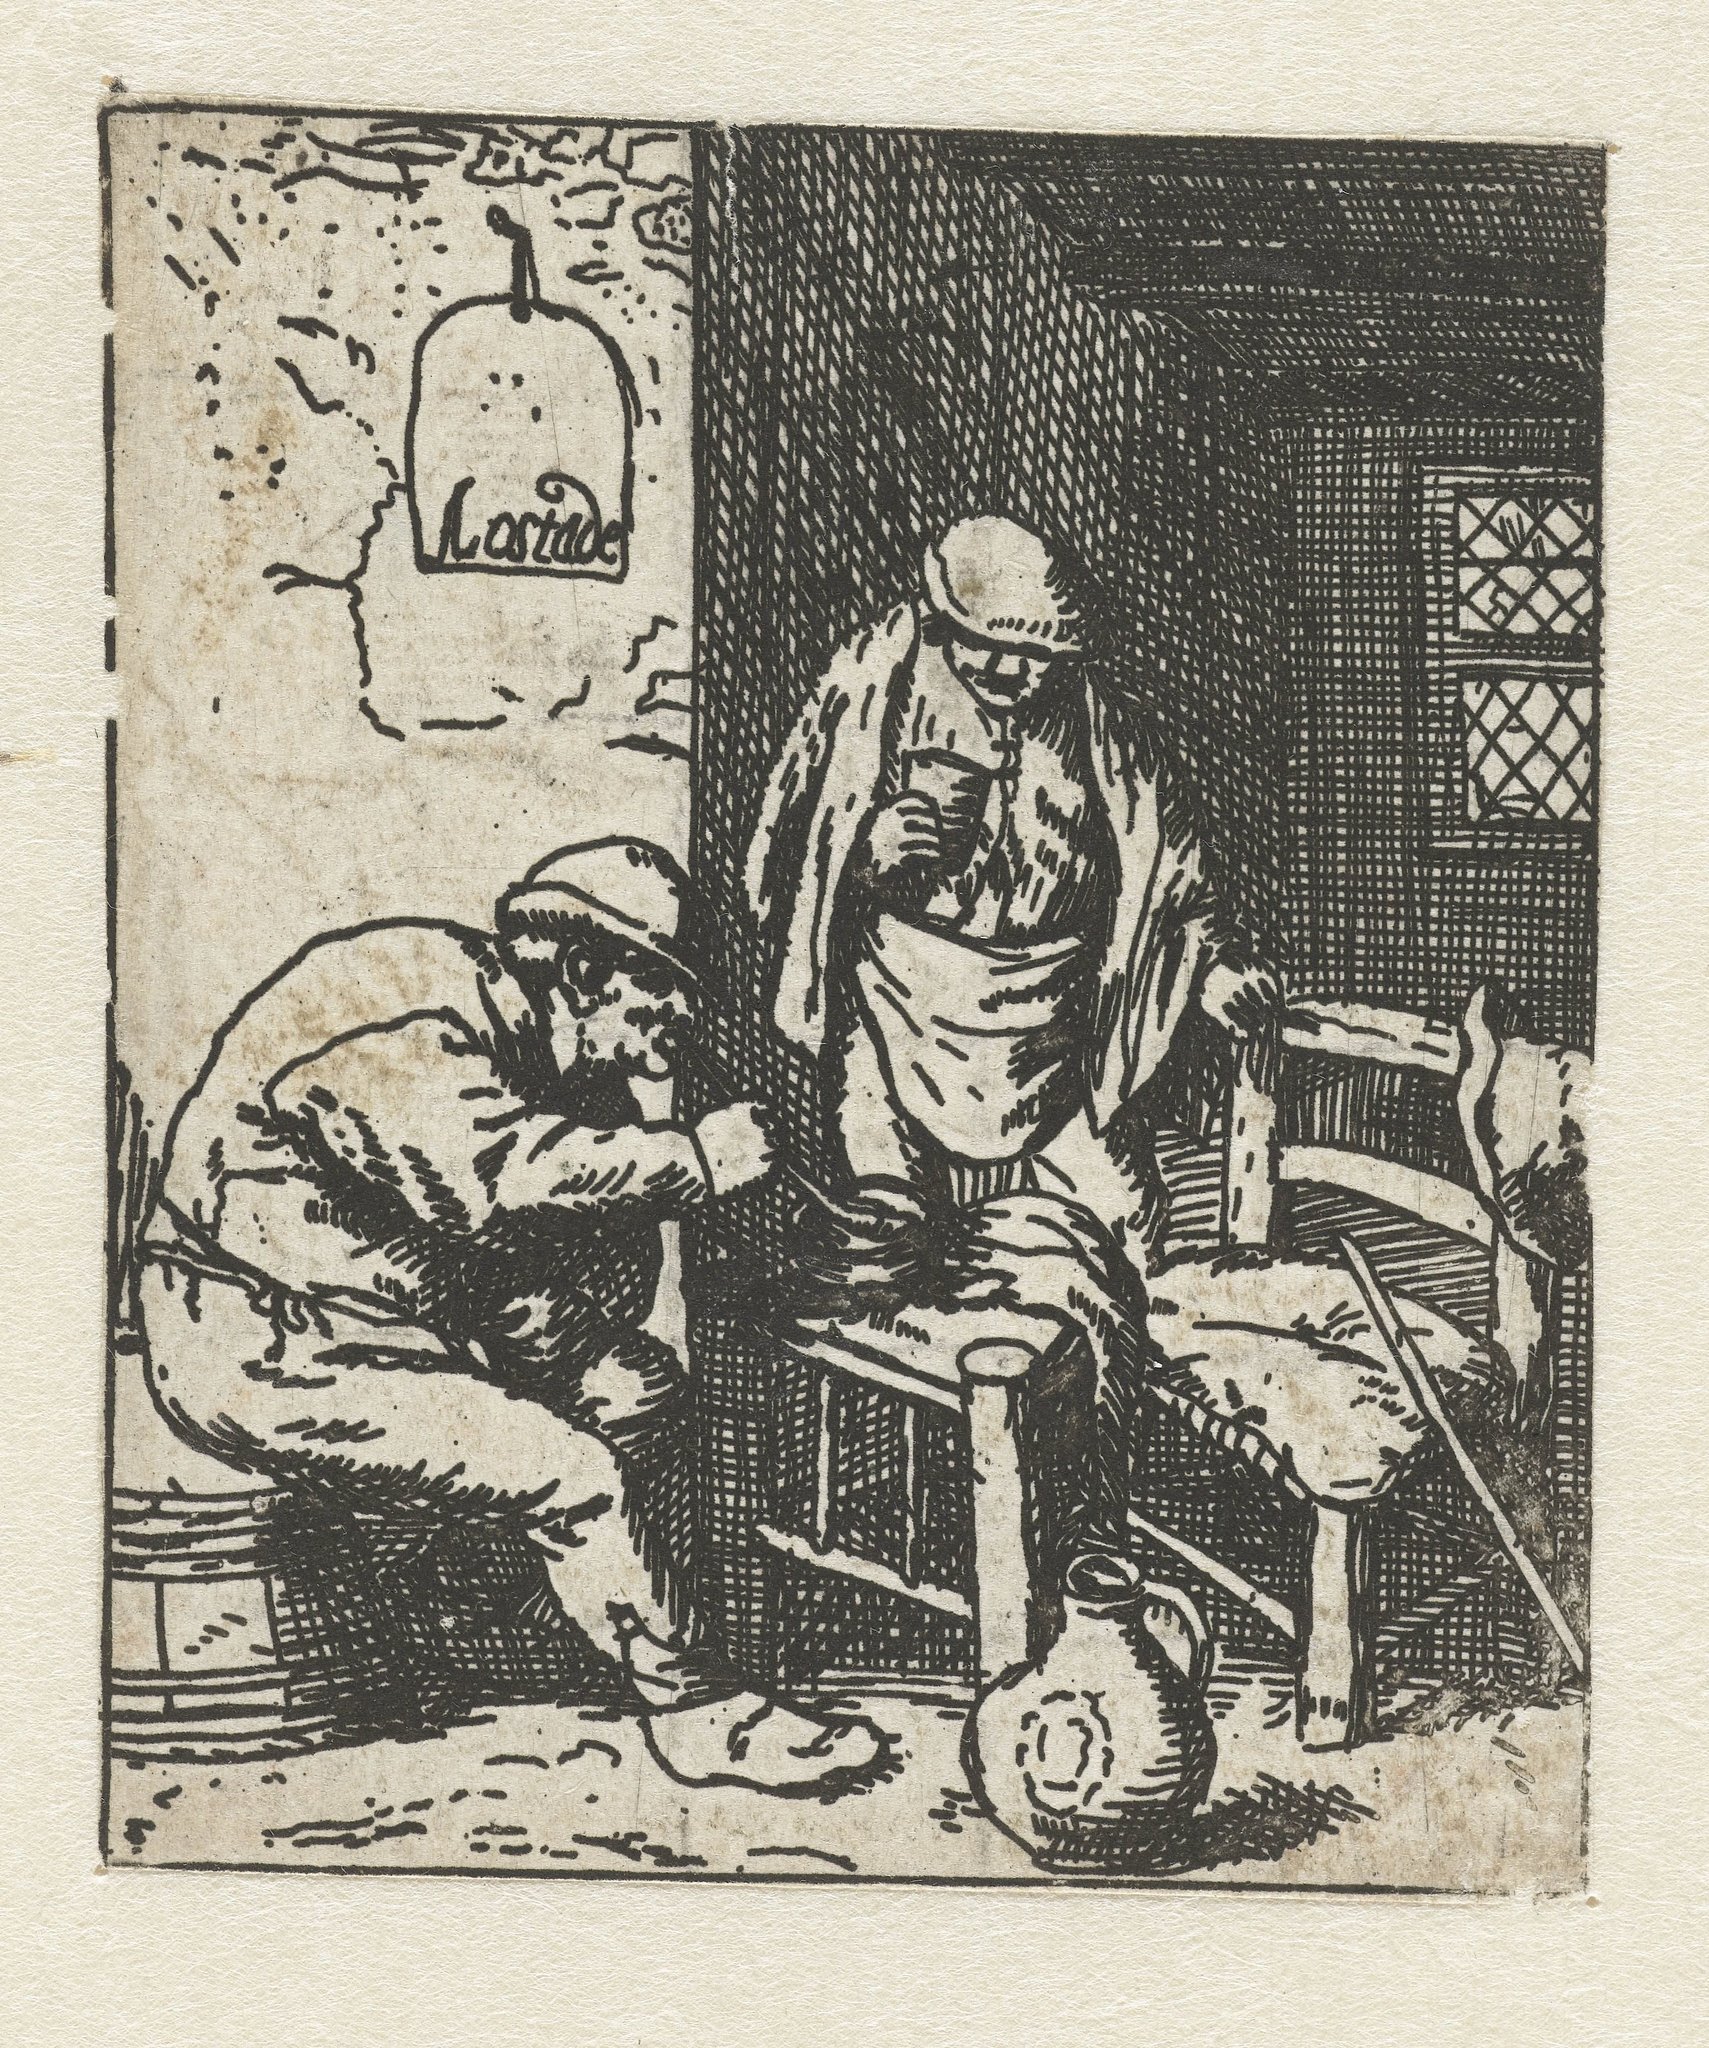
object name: kopie naar prent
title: Interieur van een herberg met man die pijp aansteekt en man met glas in zijn hand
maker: Anonymous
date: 1671-1745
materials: paper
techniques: etching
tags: inn, coffee-house, public house, etc., pipe ~ tobacco, drinking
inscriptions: collector's mark: Lugt 240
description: Kopie naar prent van Adriaen van Ostade, de voorstelling is spiegelverkeerd weergegeven op een iets kleiner formaat